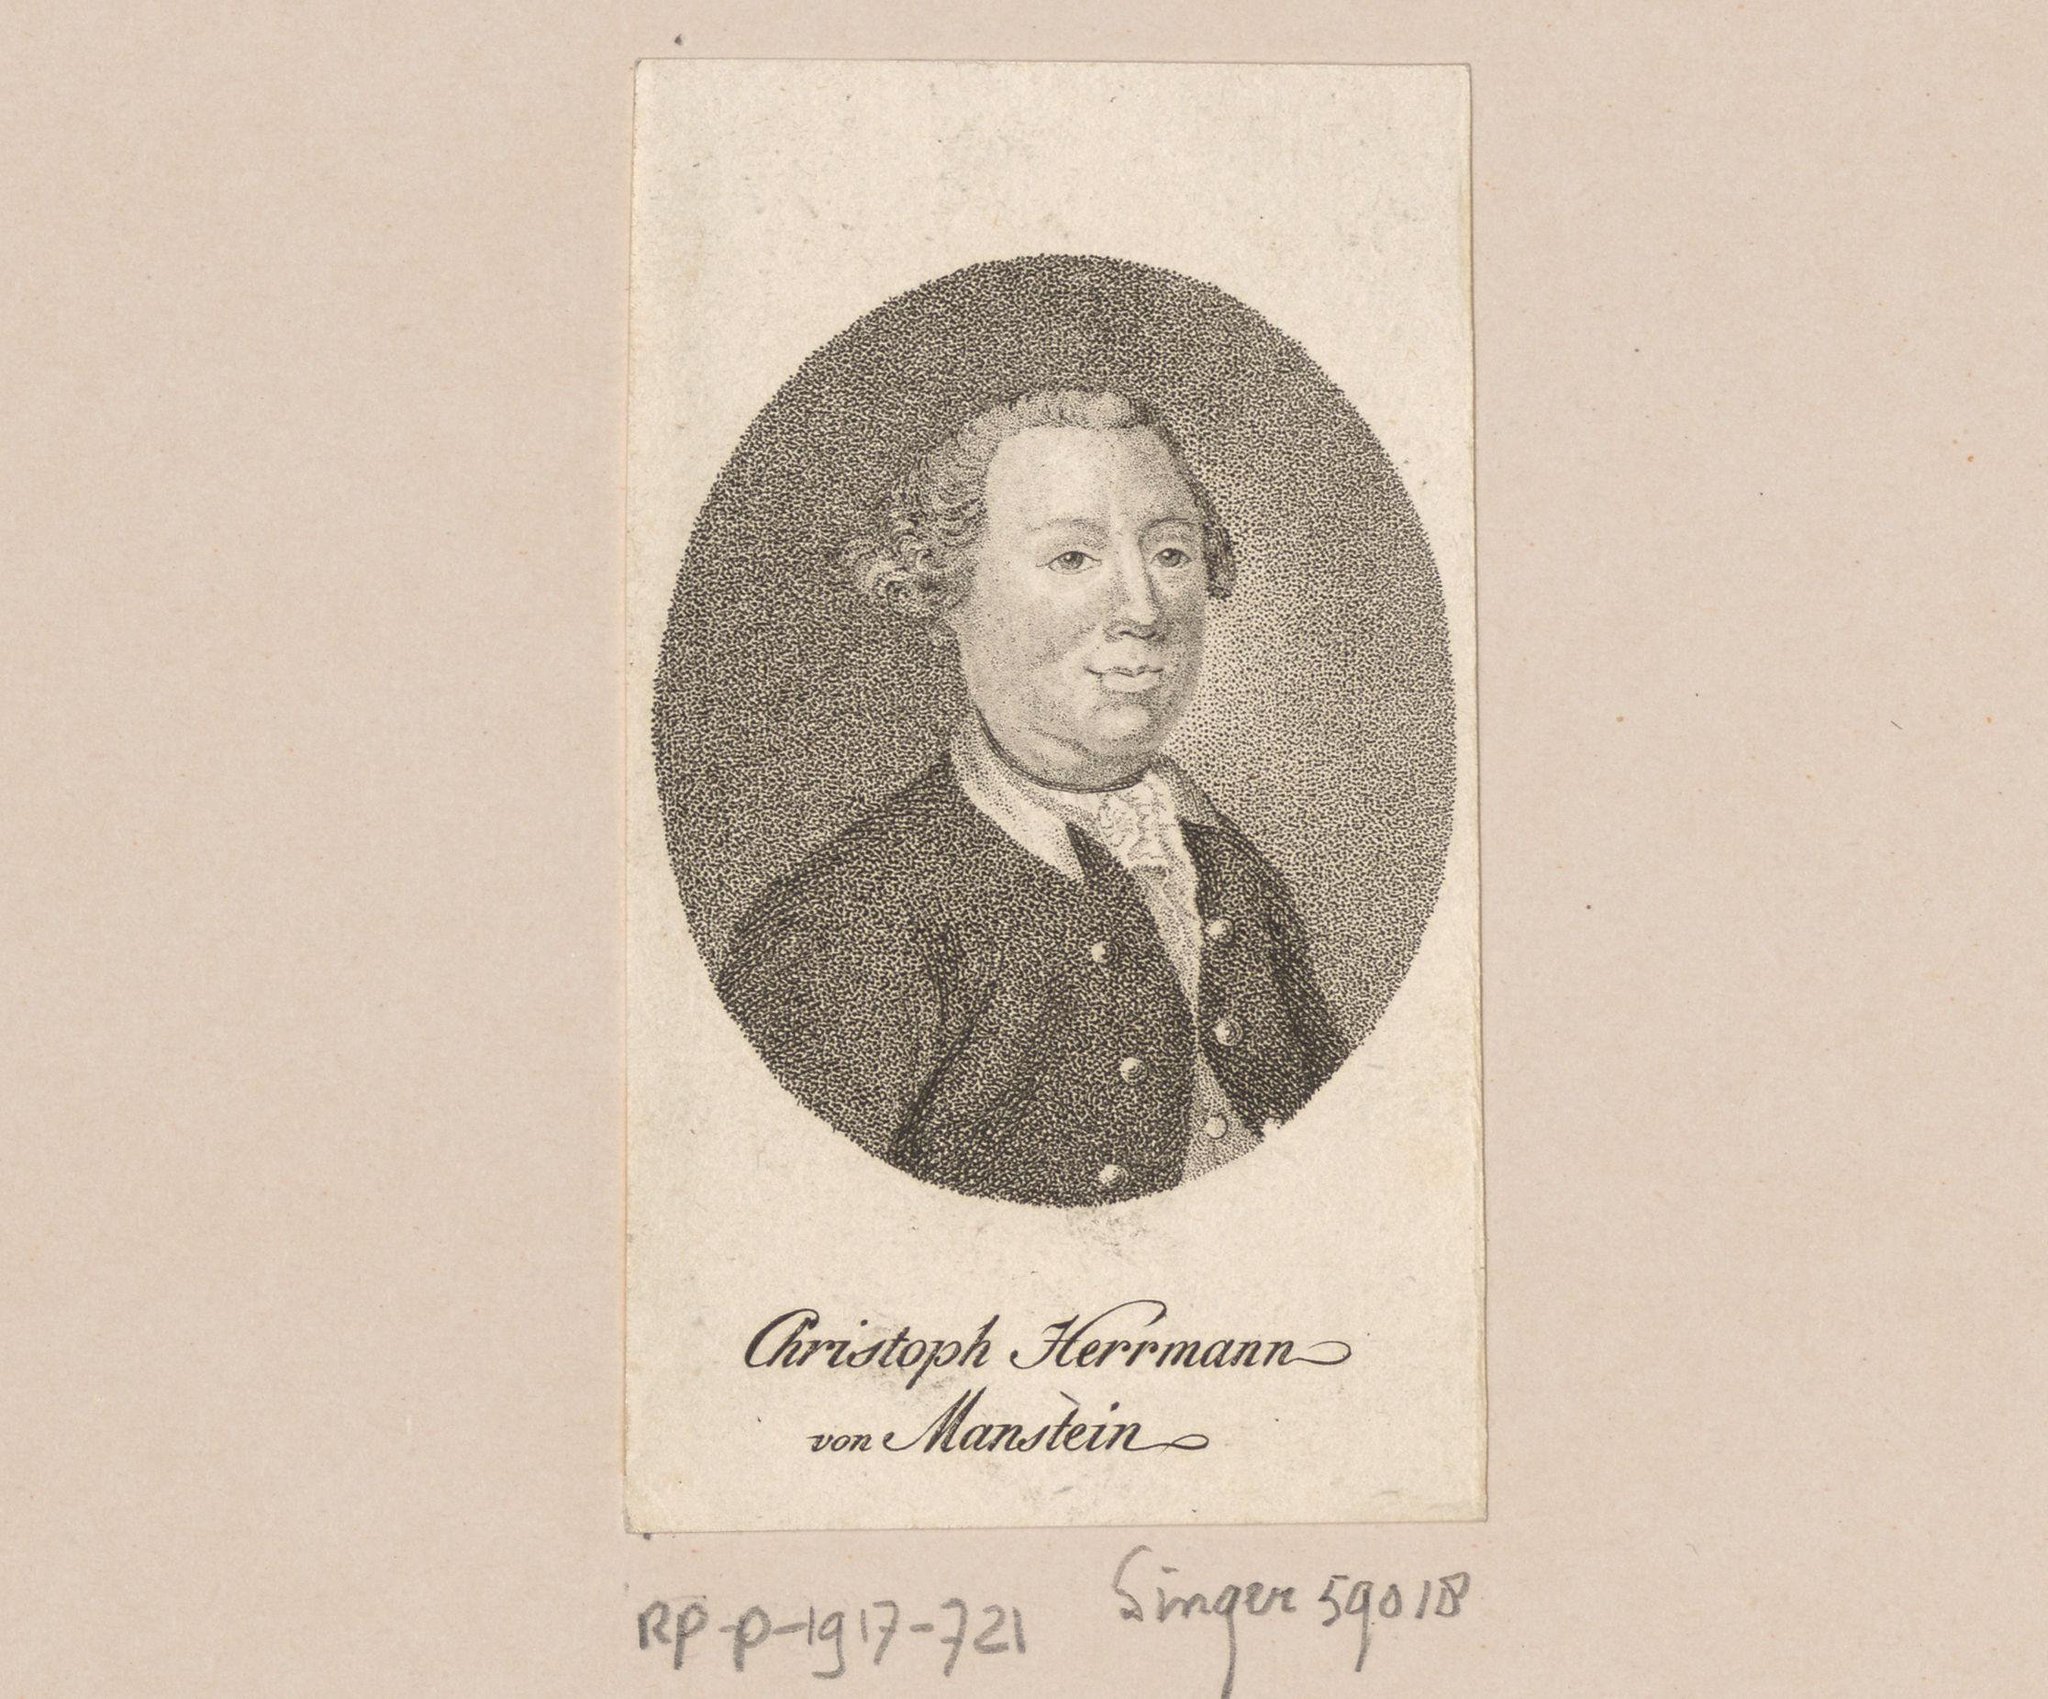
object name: print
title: Portret van Christoph Hermann von Manstein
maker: Anonymous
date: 1740-1799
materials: paper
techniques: stippling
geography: germany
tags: commander-in-chief, general, marshal, historical persons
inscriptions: collector's mark: Lugt 2228